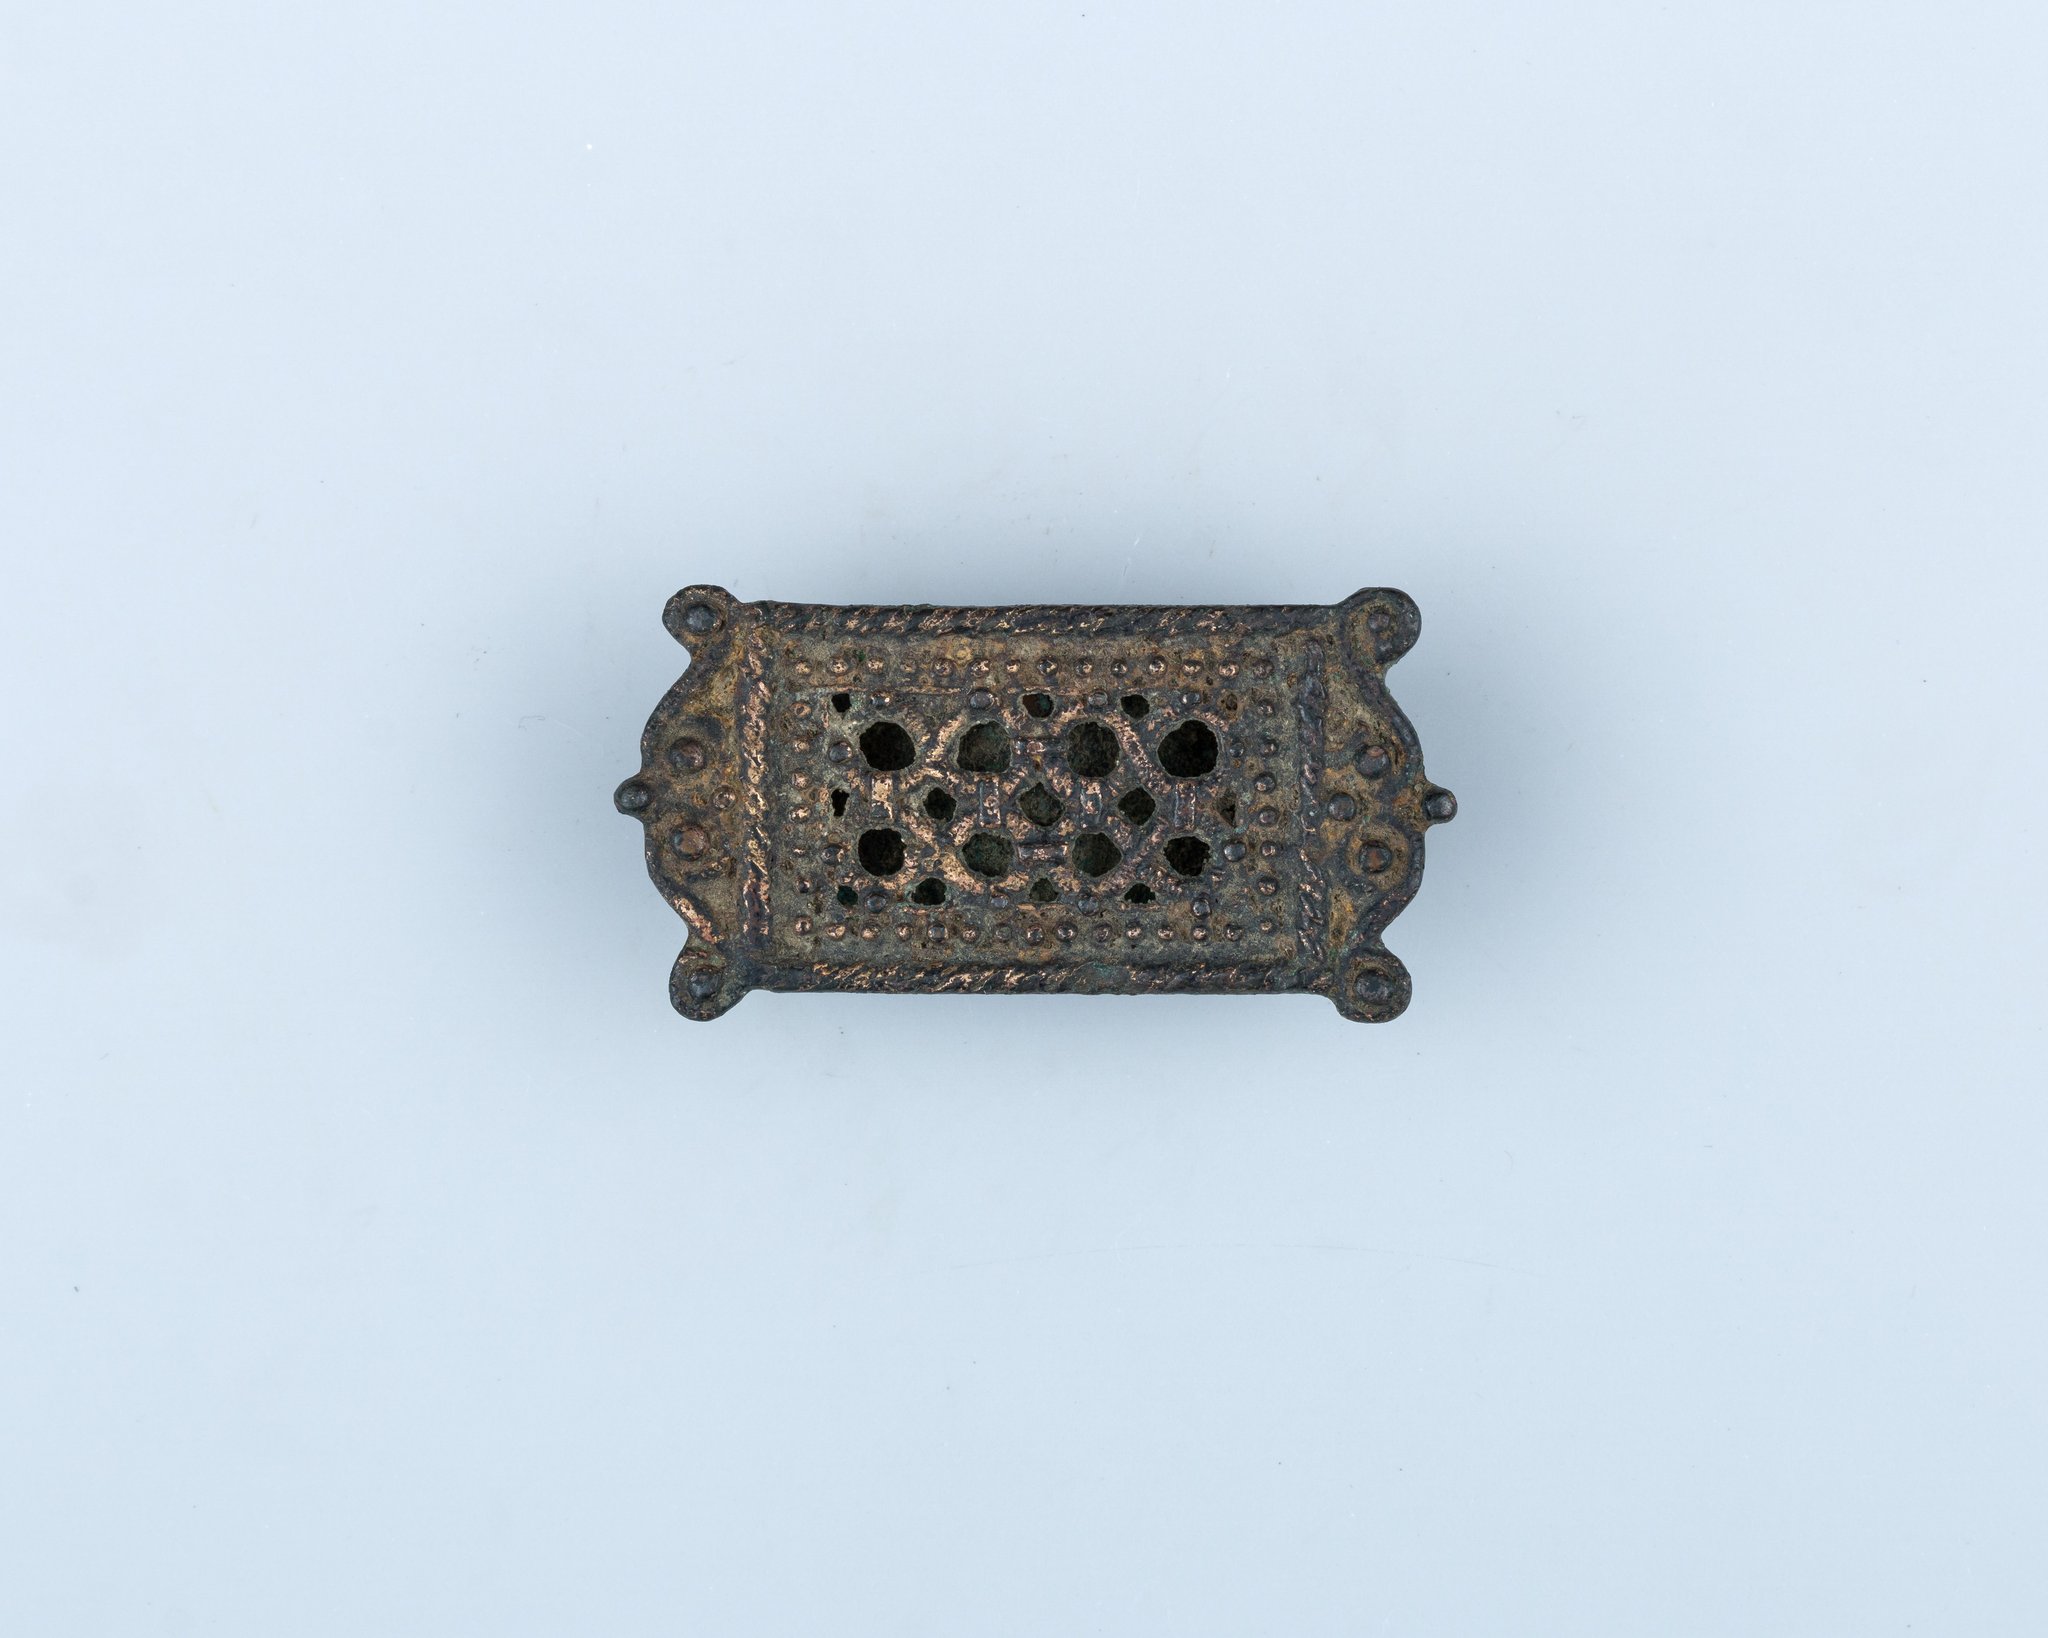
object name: slide for strap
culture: european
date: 1401-1700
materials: bronze, gilt